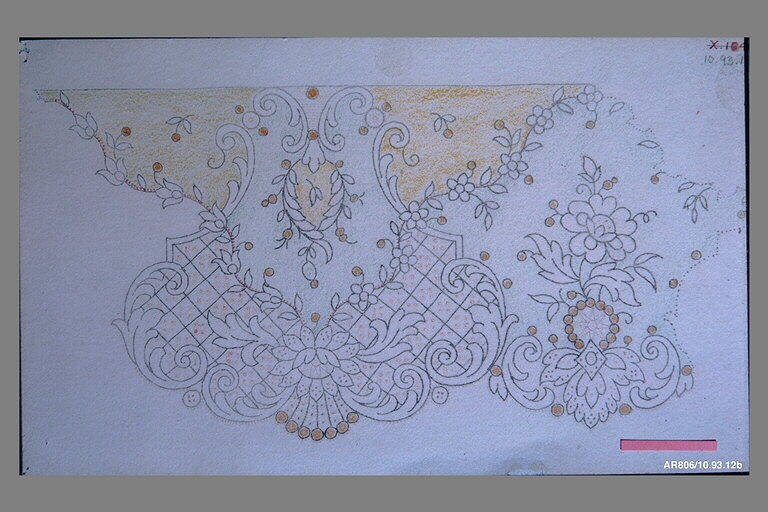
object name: pattern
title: Lace pattern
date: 1801-1900